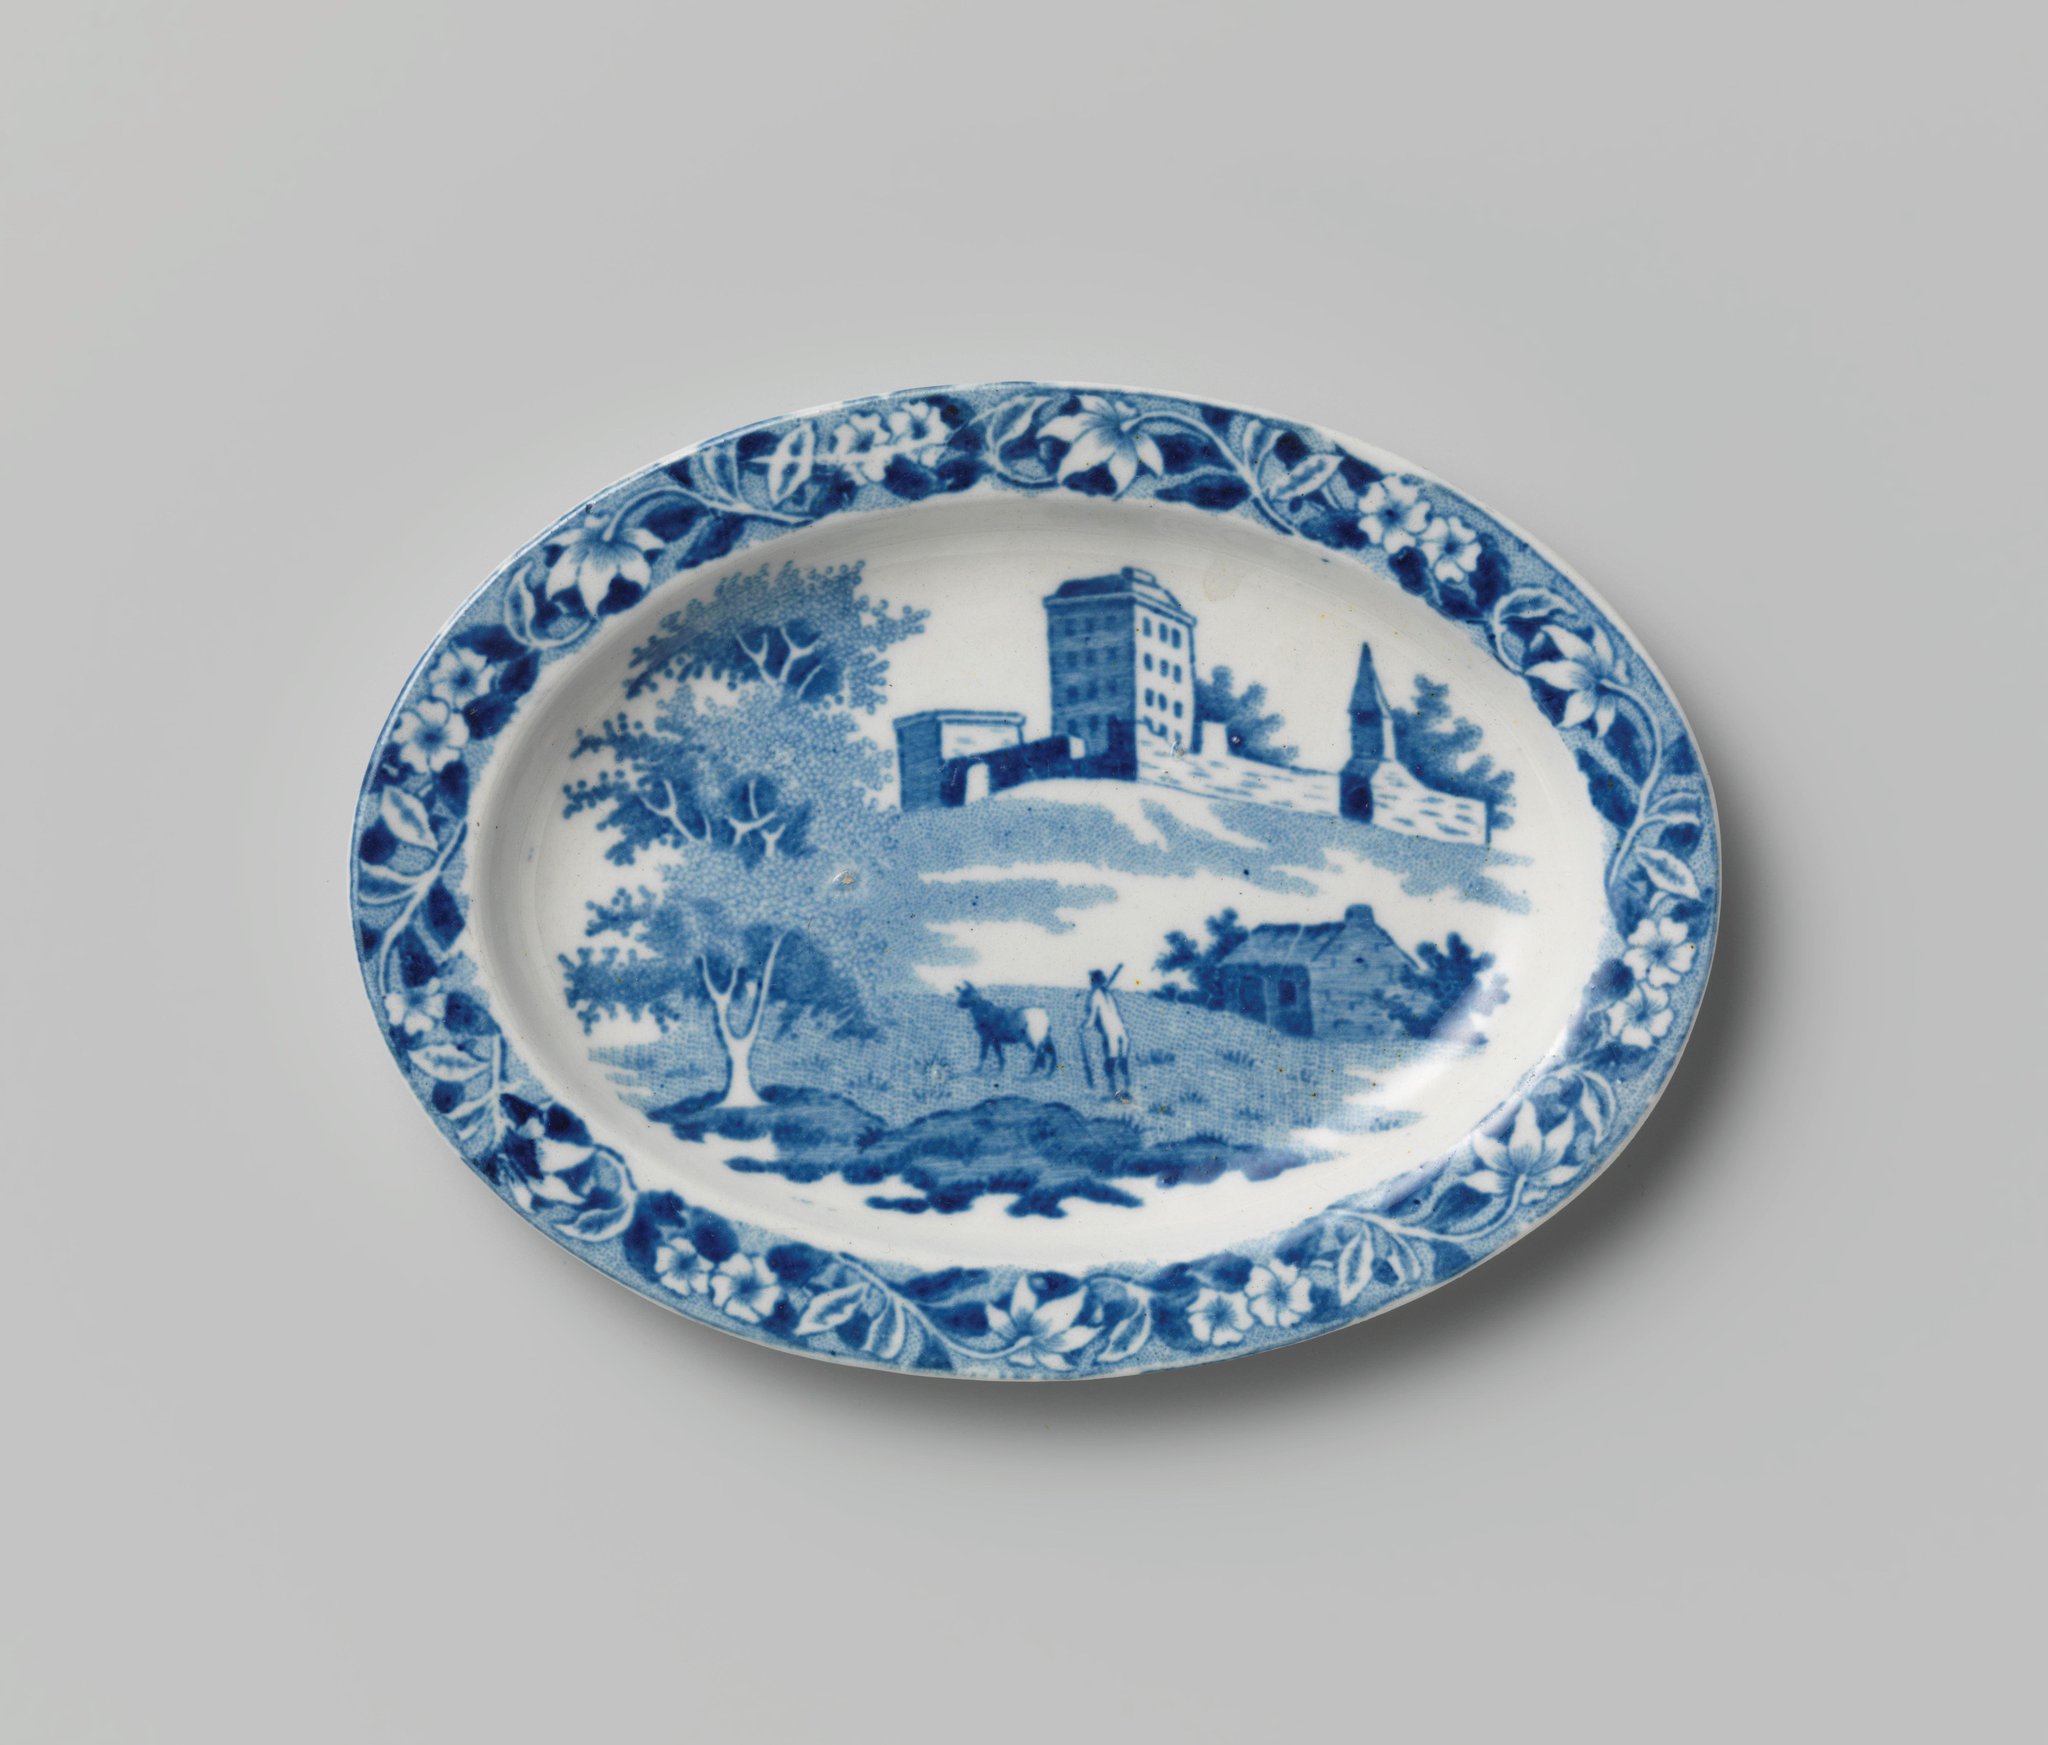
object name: platter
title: Ovale schotel van hardgebakken aardewerk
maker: Anonymous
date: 1840-1860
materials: earthenware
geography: shelton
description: Ovale schotel van hardgebakken aardewerk met op het plat een decoratie in blauw van een landschap met gebouwen, een boom en een man met een dier. De rand is versierd met bloemtakken.